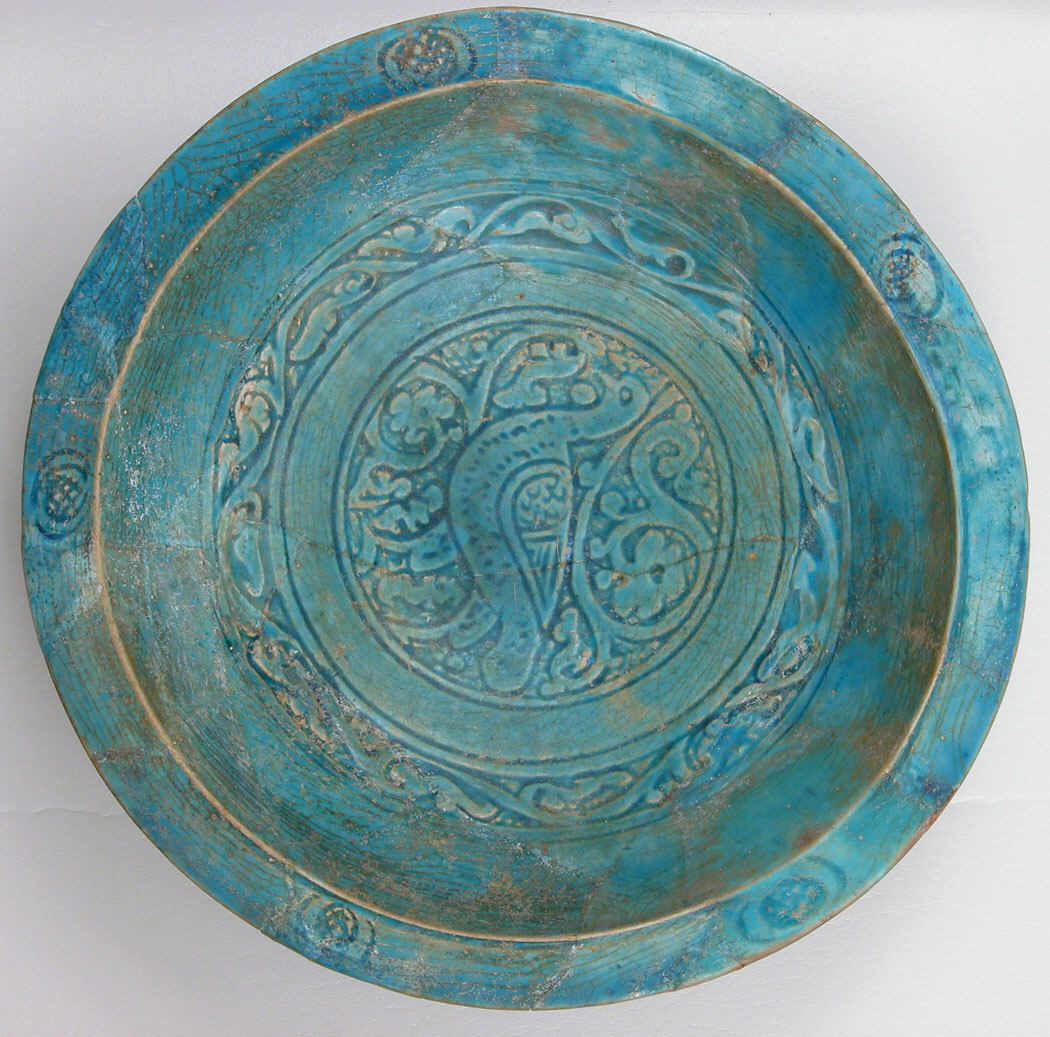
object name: bowl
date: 1101-1200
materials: stonepaste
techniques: carving, glazing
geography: iran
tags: birds